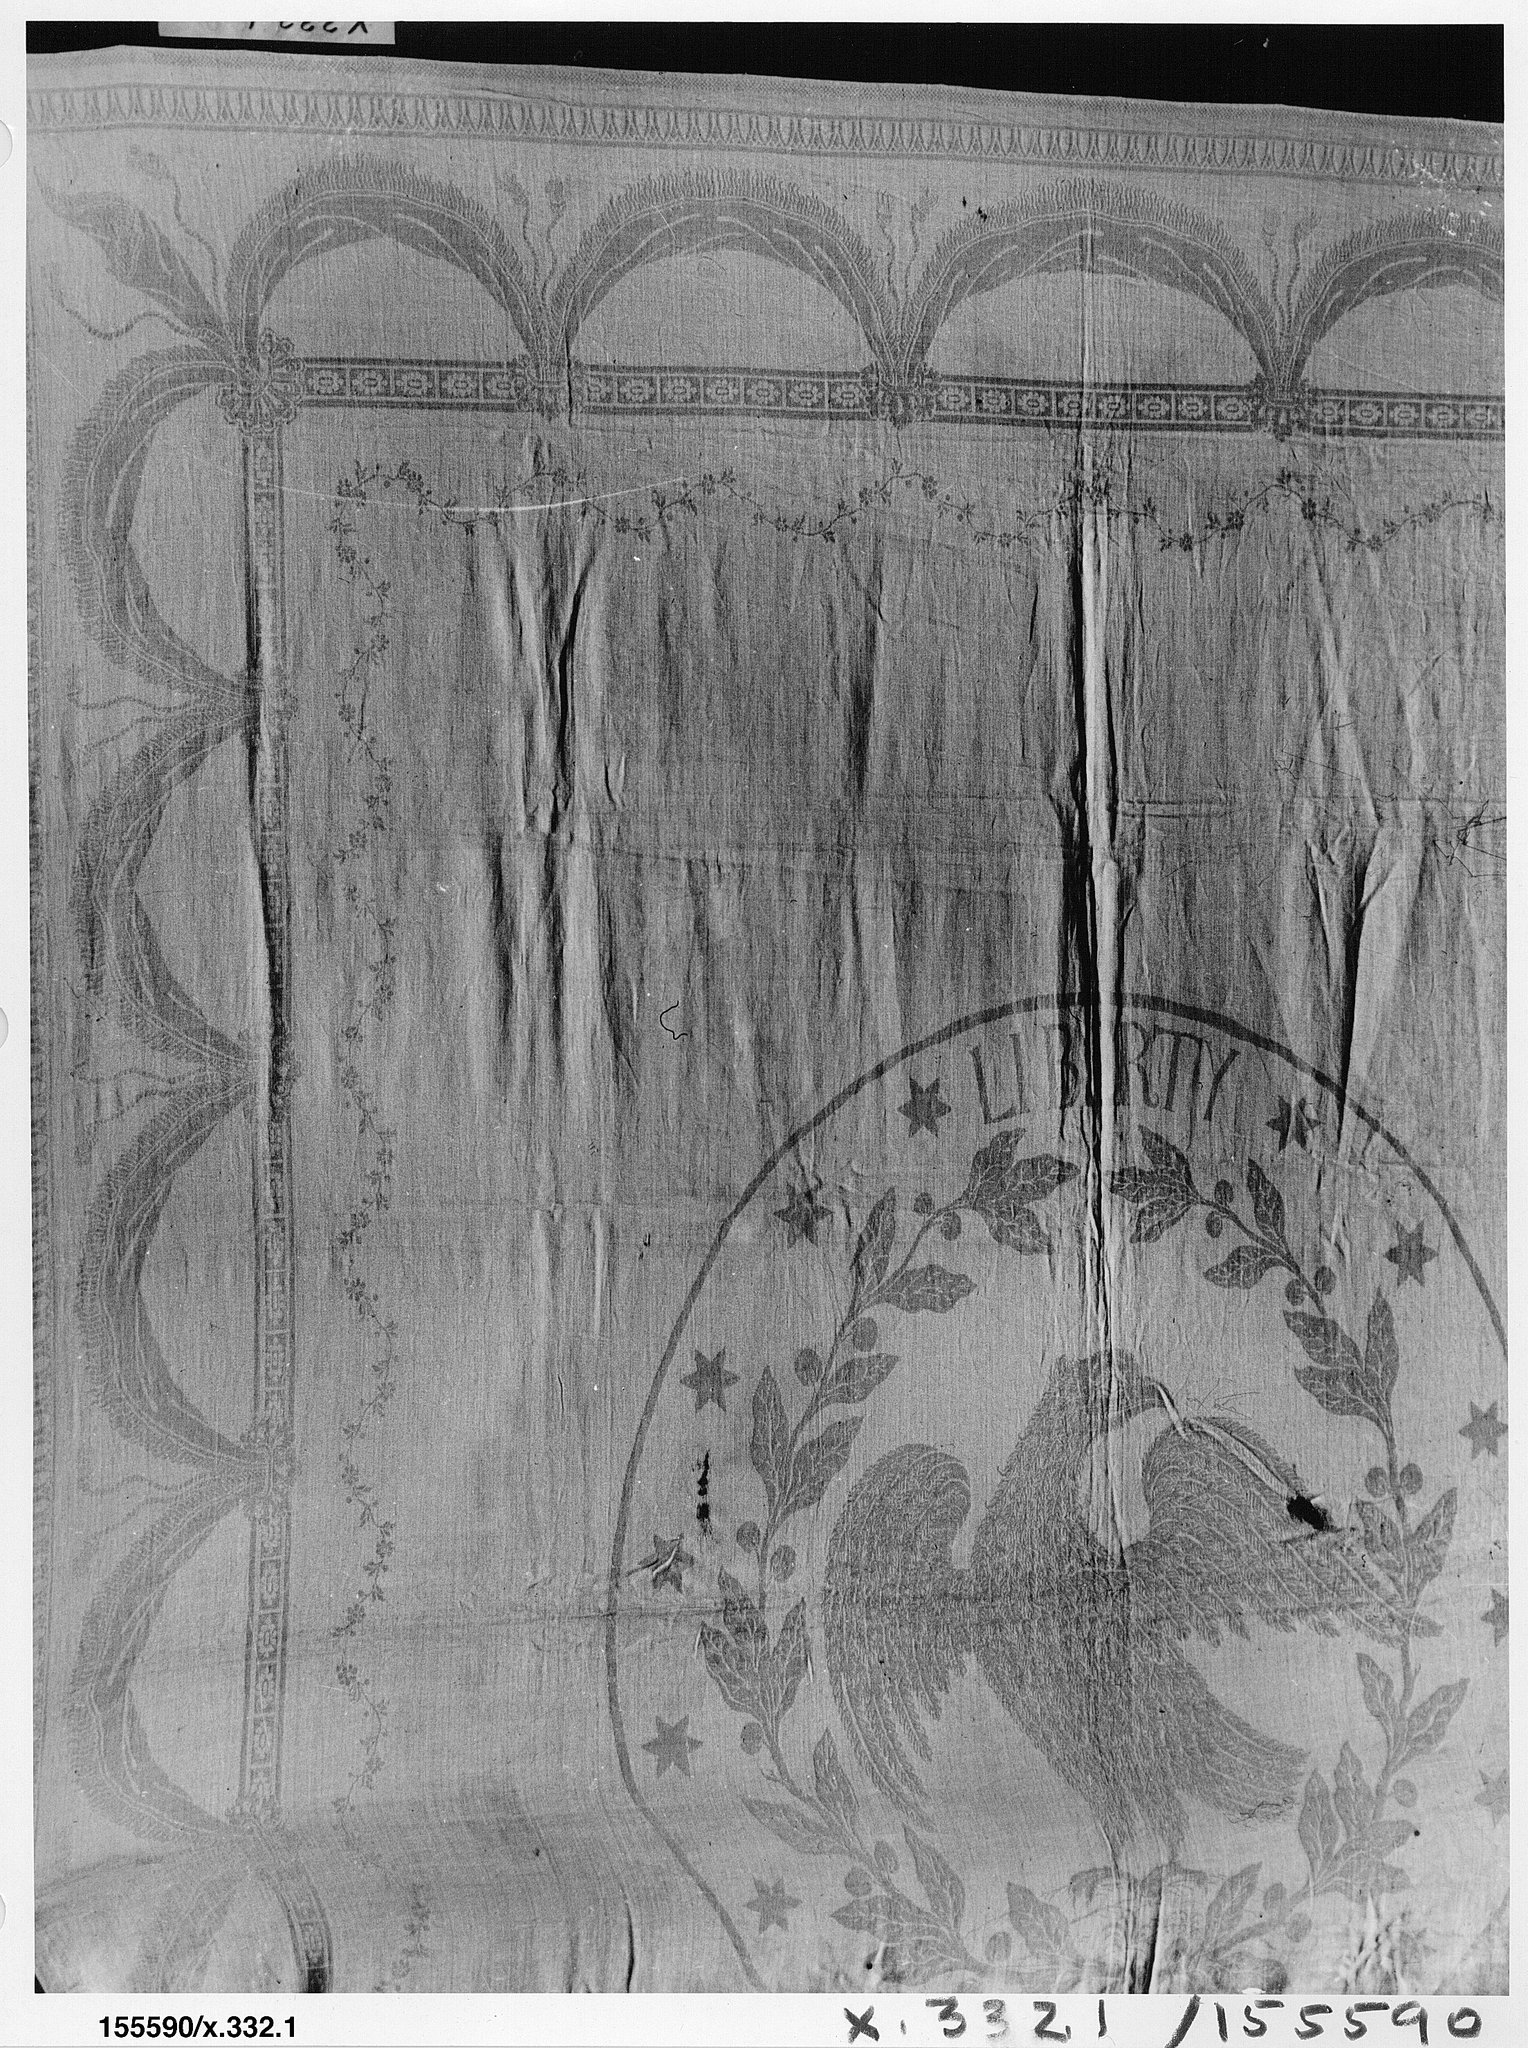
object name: tablecloth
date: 1795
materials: linen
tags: birds